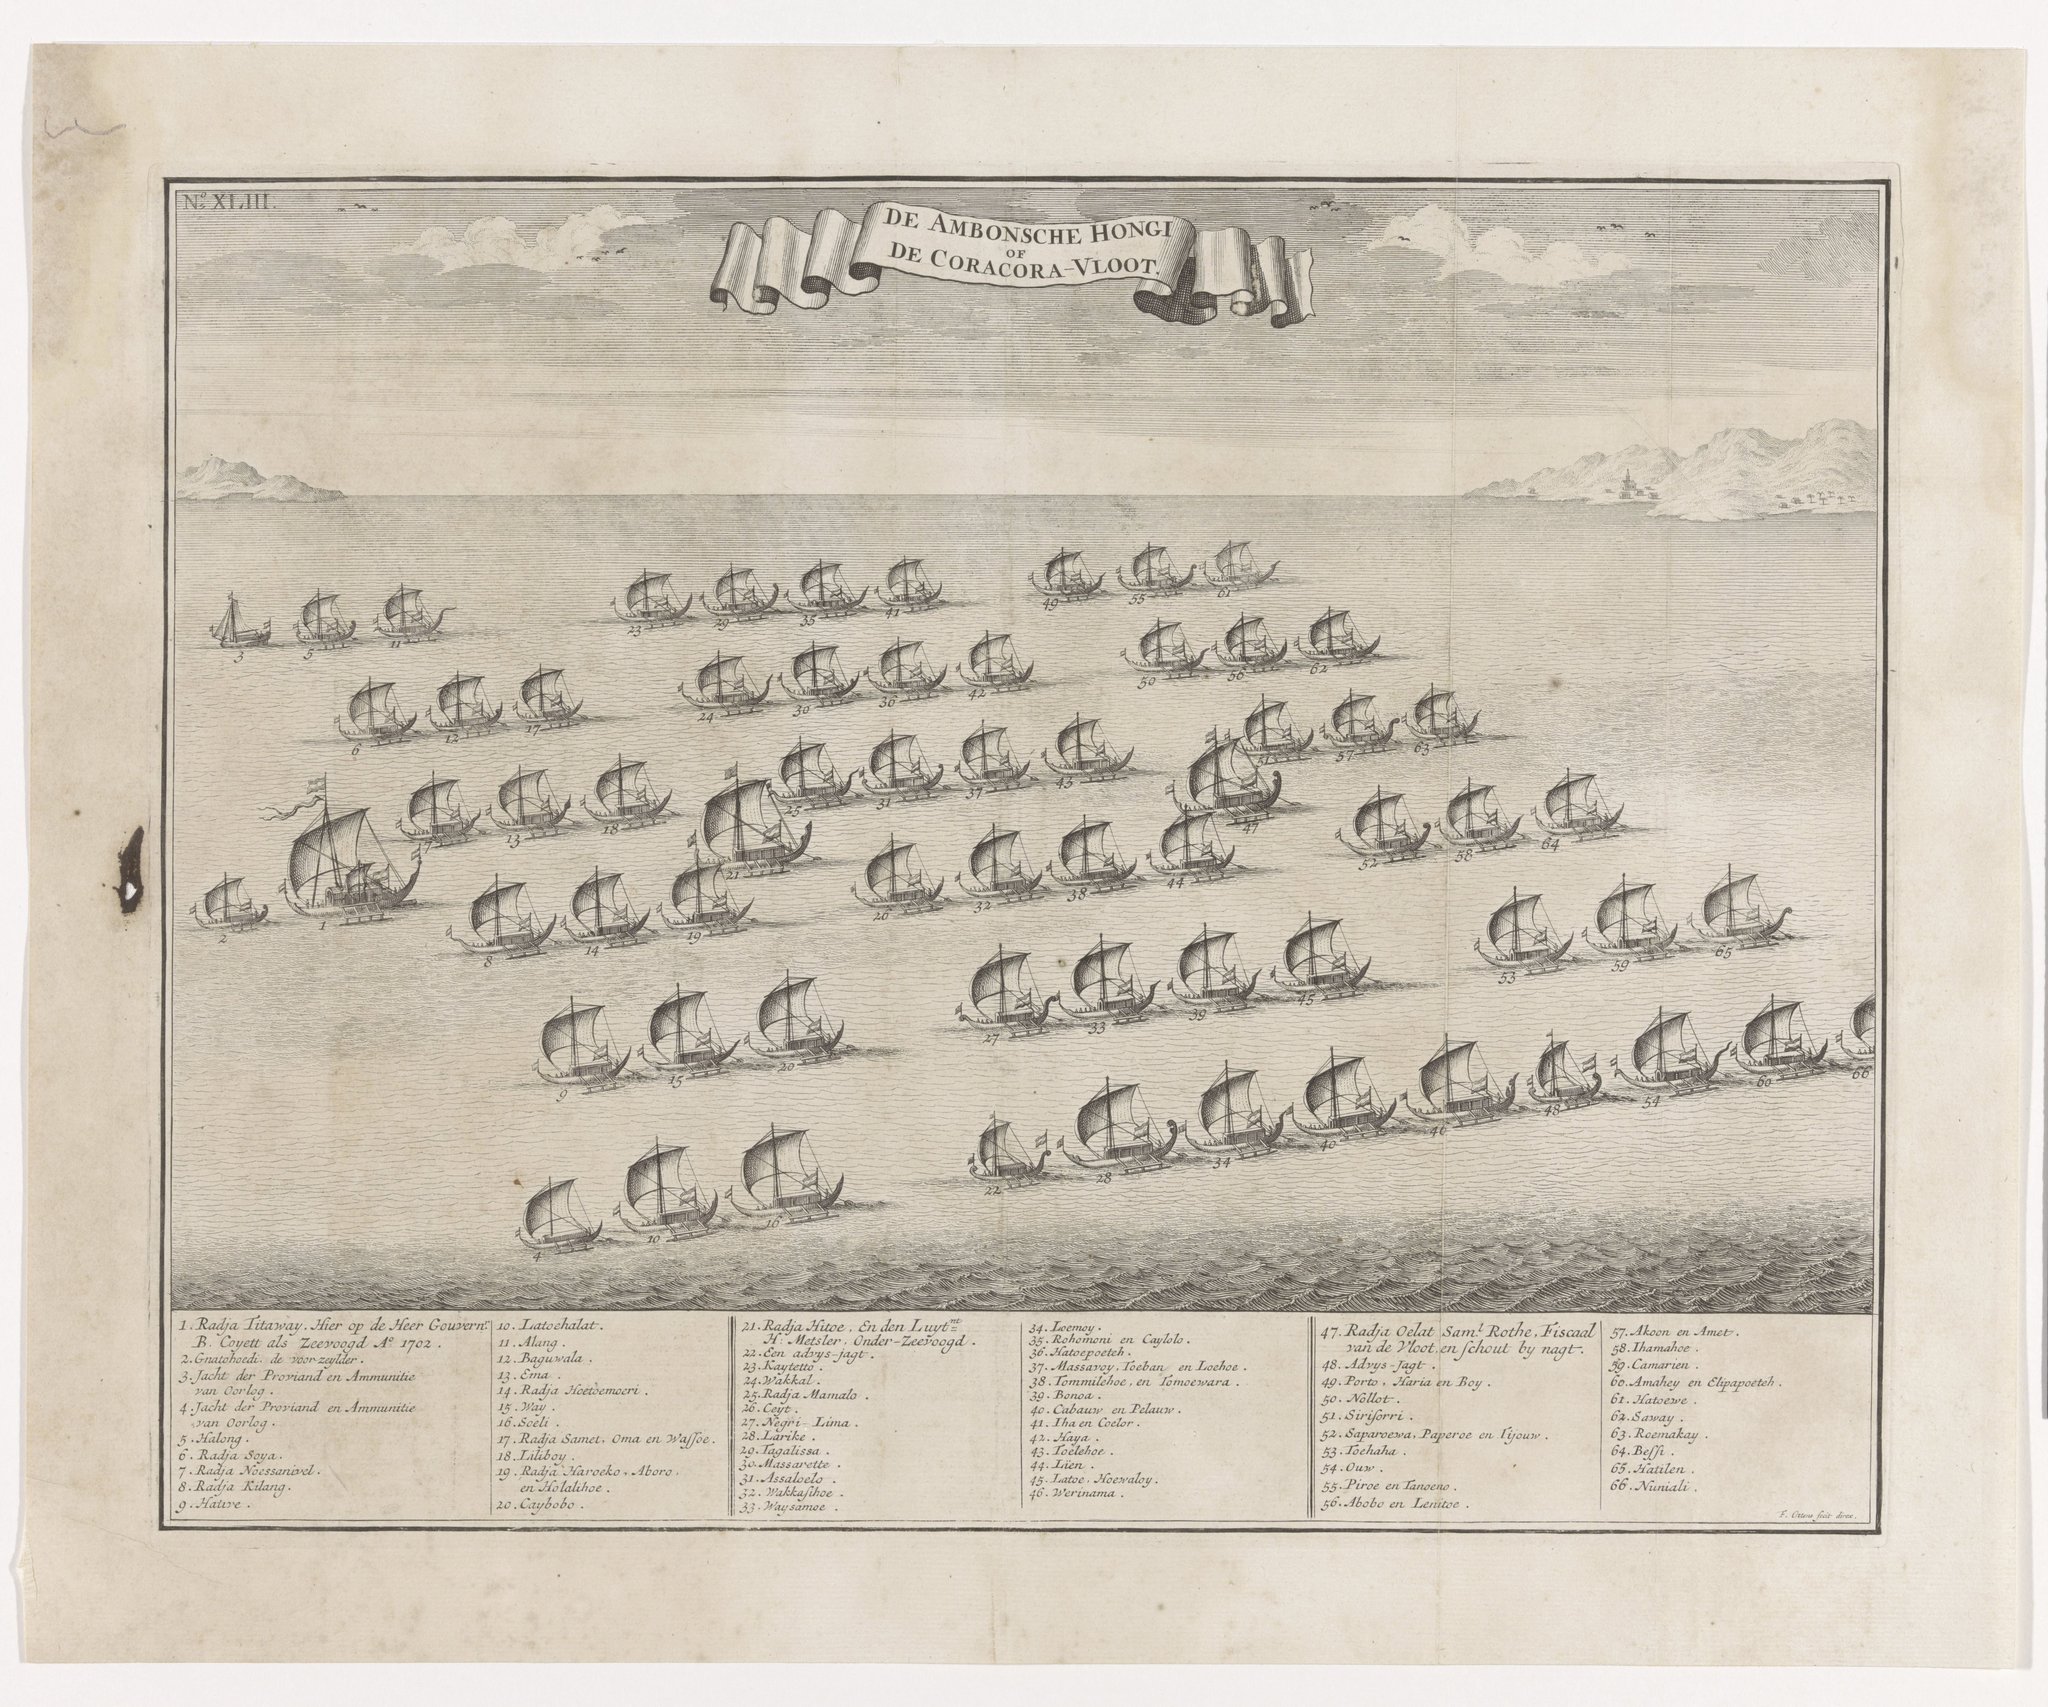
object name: print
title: De Ambonsche Hongi of De Coracora-Vloot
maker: frederik ottens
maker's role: draughtsman, print maker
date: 1717-1770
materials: paper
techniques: engraving, etching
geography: northern netherlands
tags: verenigde oostindische compagnie, ambon